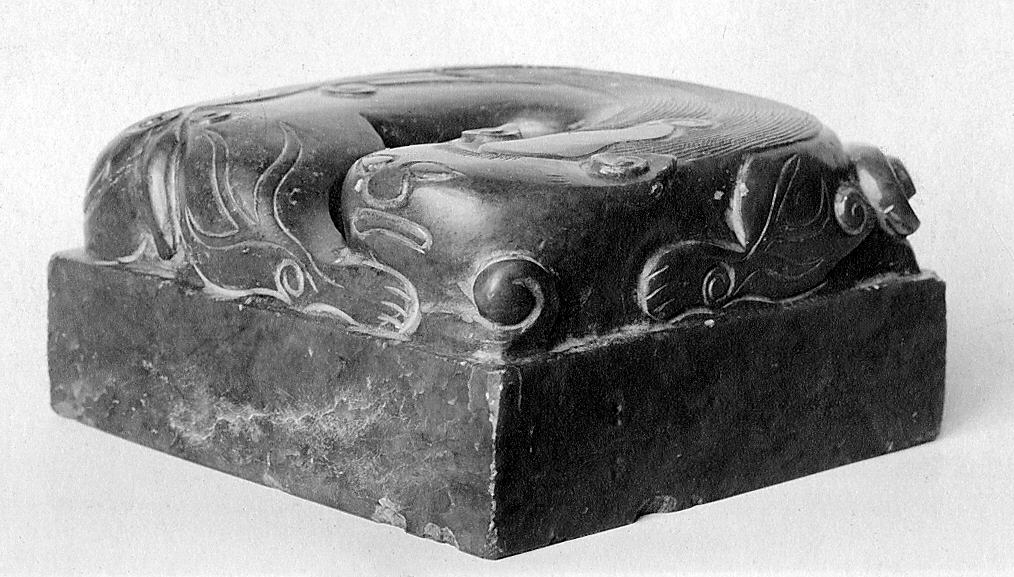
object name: imperial seal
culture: chinese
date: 960-1279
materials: jade